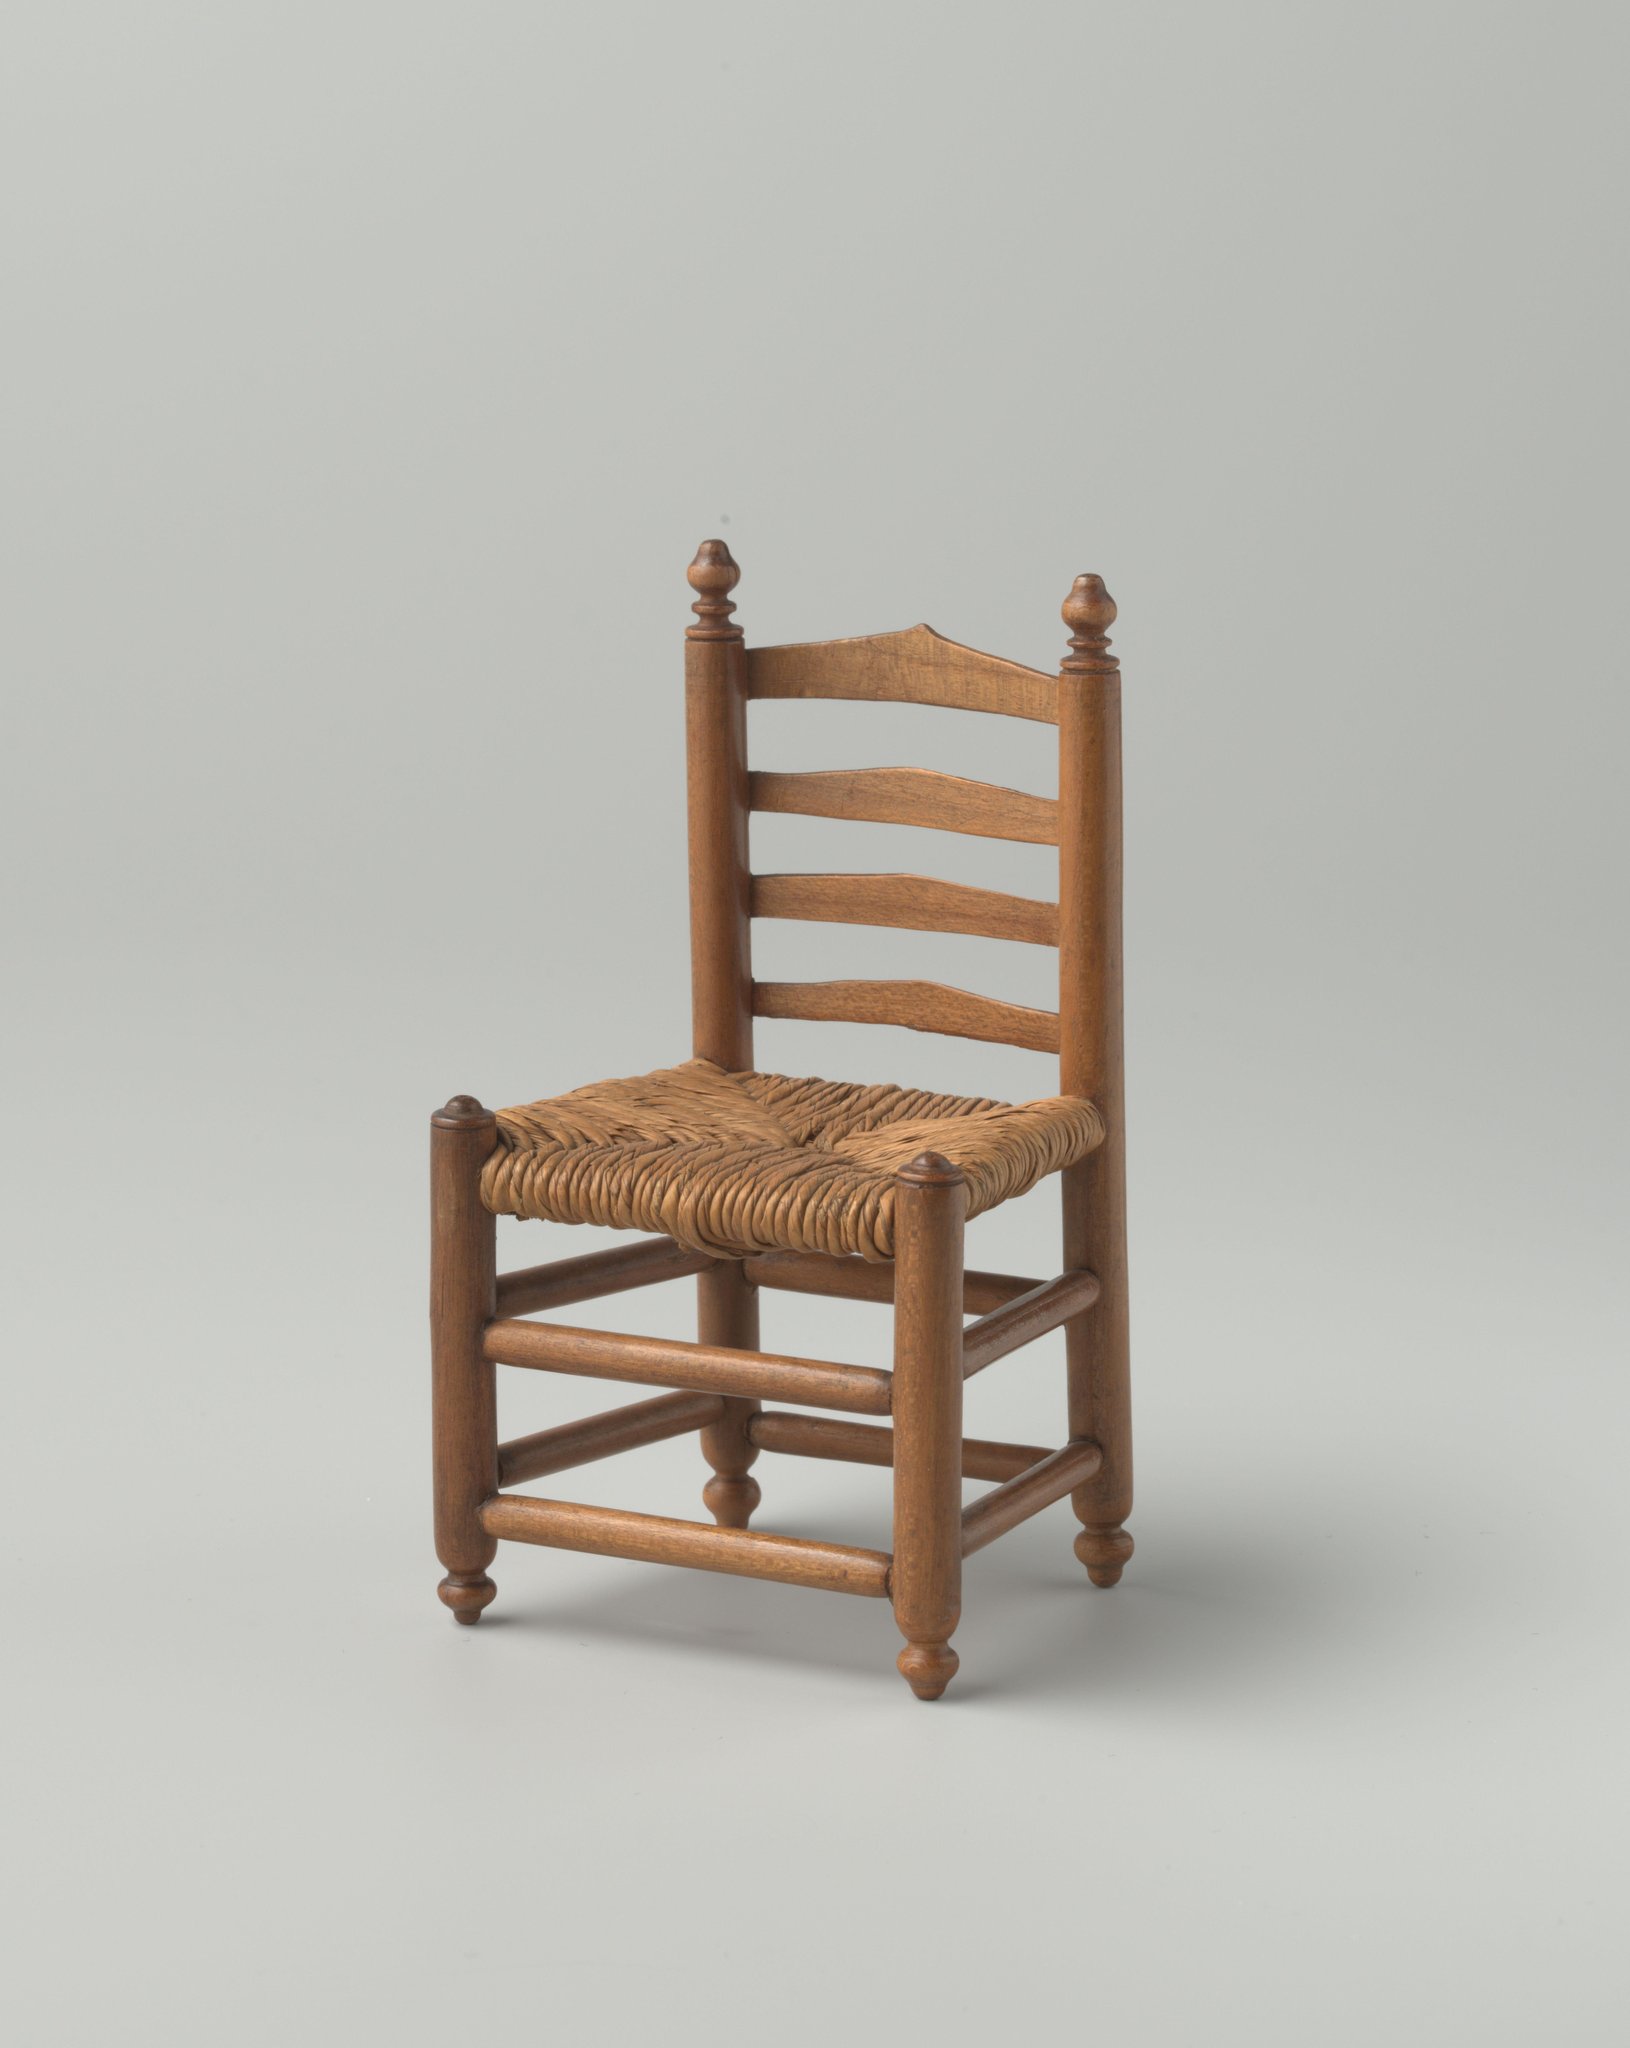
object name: miniature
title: Knopstoel vervaardigd van esdoornhout met gladde, gedraaide stijlen en dwarsregels, voorpoten en achterstijlen eindid in fijn gedraaide knoppen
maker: Anonymous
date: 1690-1710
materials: wood, fiber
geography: amsterdam